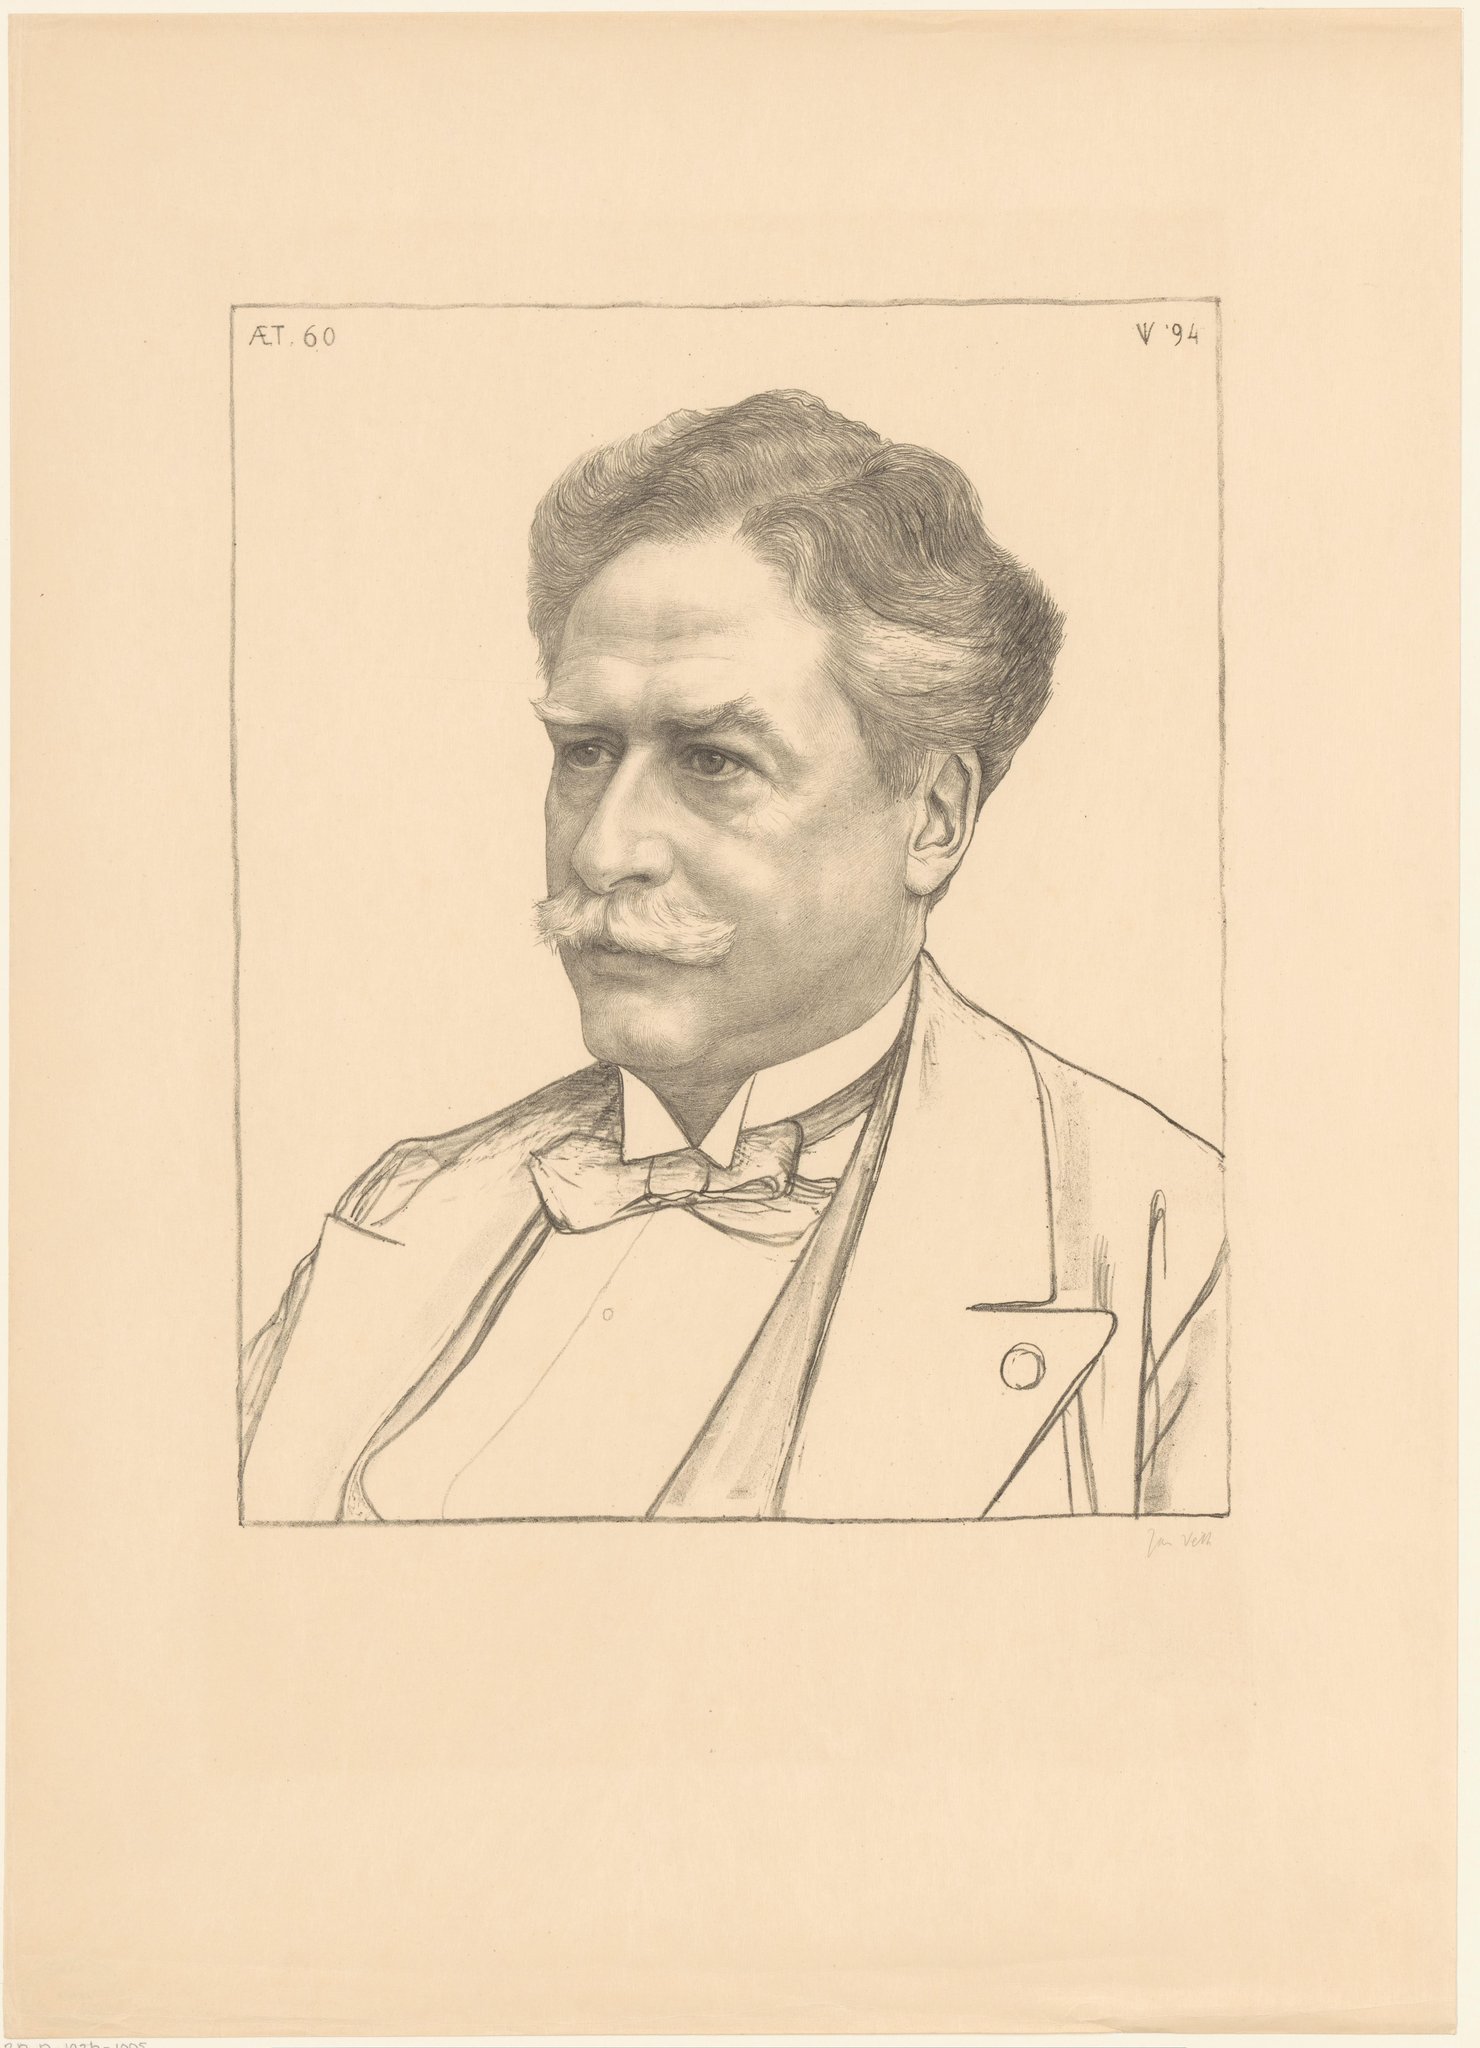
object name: print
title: Bekende tijdgenooten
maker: jan veth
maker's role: designer, draughtsman, painter, print maker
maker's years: 1864-1925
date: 1894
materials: paper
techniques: lithograph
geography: netherlands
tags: zeist, utrecht, historical persons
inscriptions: inscription: ‘Jan Veth’, collector's mark: Lugt 2228, collector's mark: ‘H.G. Samson Amsterdam’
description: Deze prent werd uitgegeven als bijvoegsel van De Amsterdammer op 13 mei 1894.